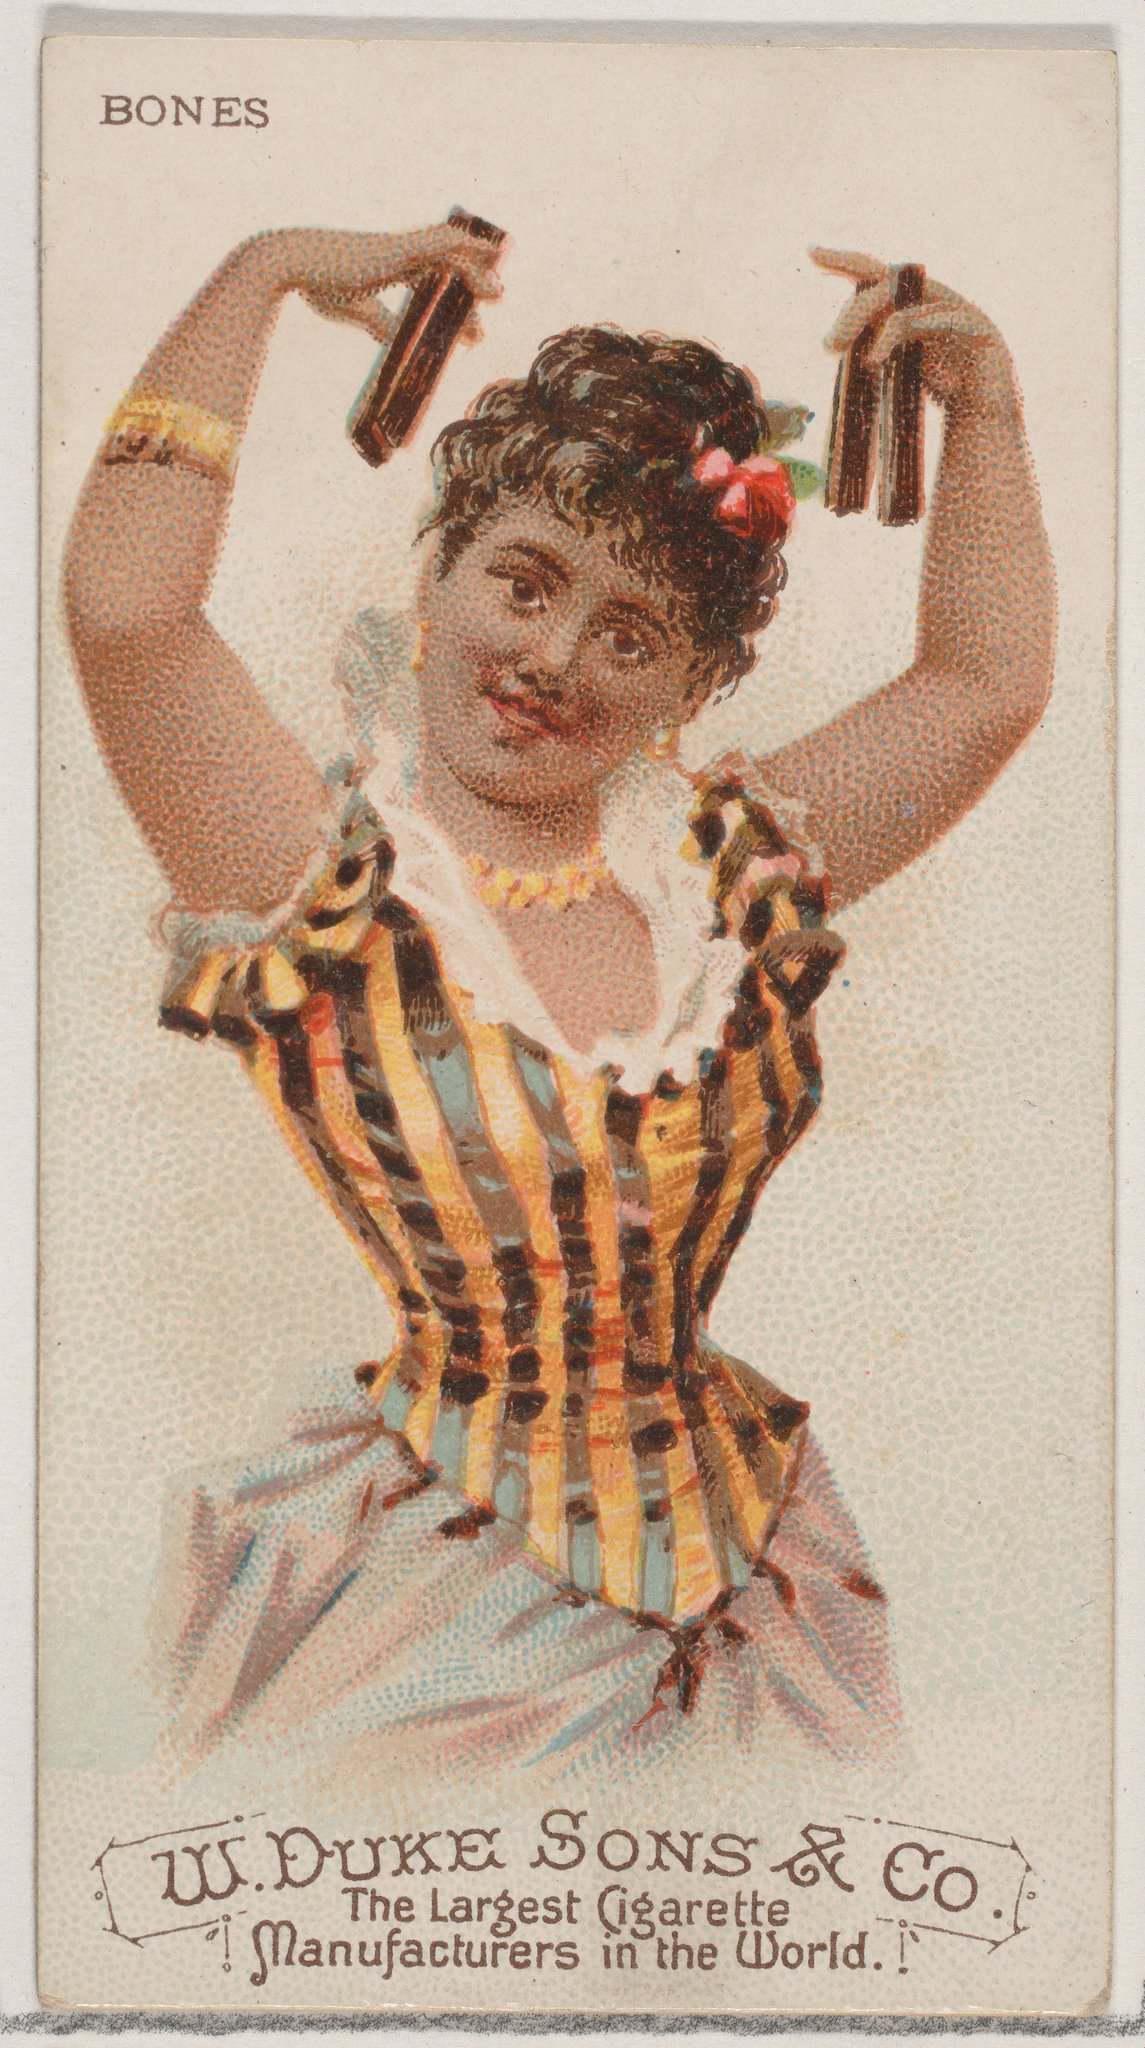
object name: print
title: Bones, from the Musical Instruments series (N82) for Duke brand cigarettes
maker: w. duke, sons & co.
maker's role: publisher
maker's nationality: american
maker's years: 1870-1920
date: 1888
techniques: color lithograph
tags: musical instruments,women,musicians